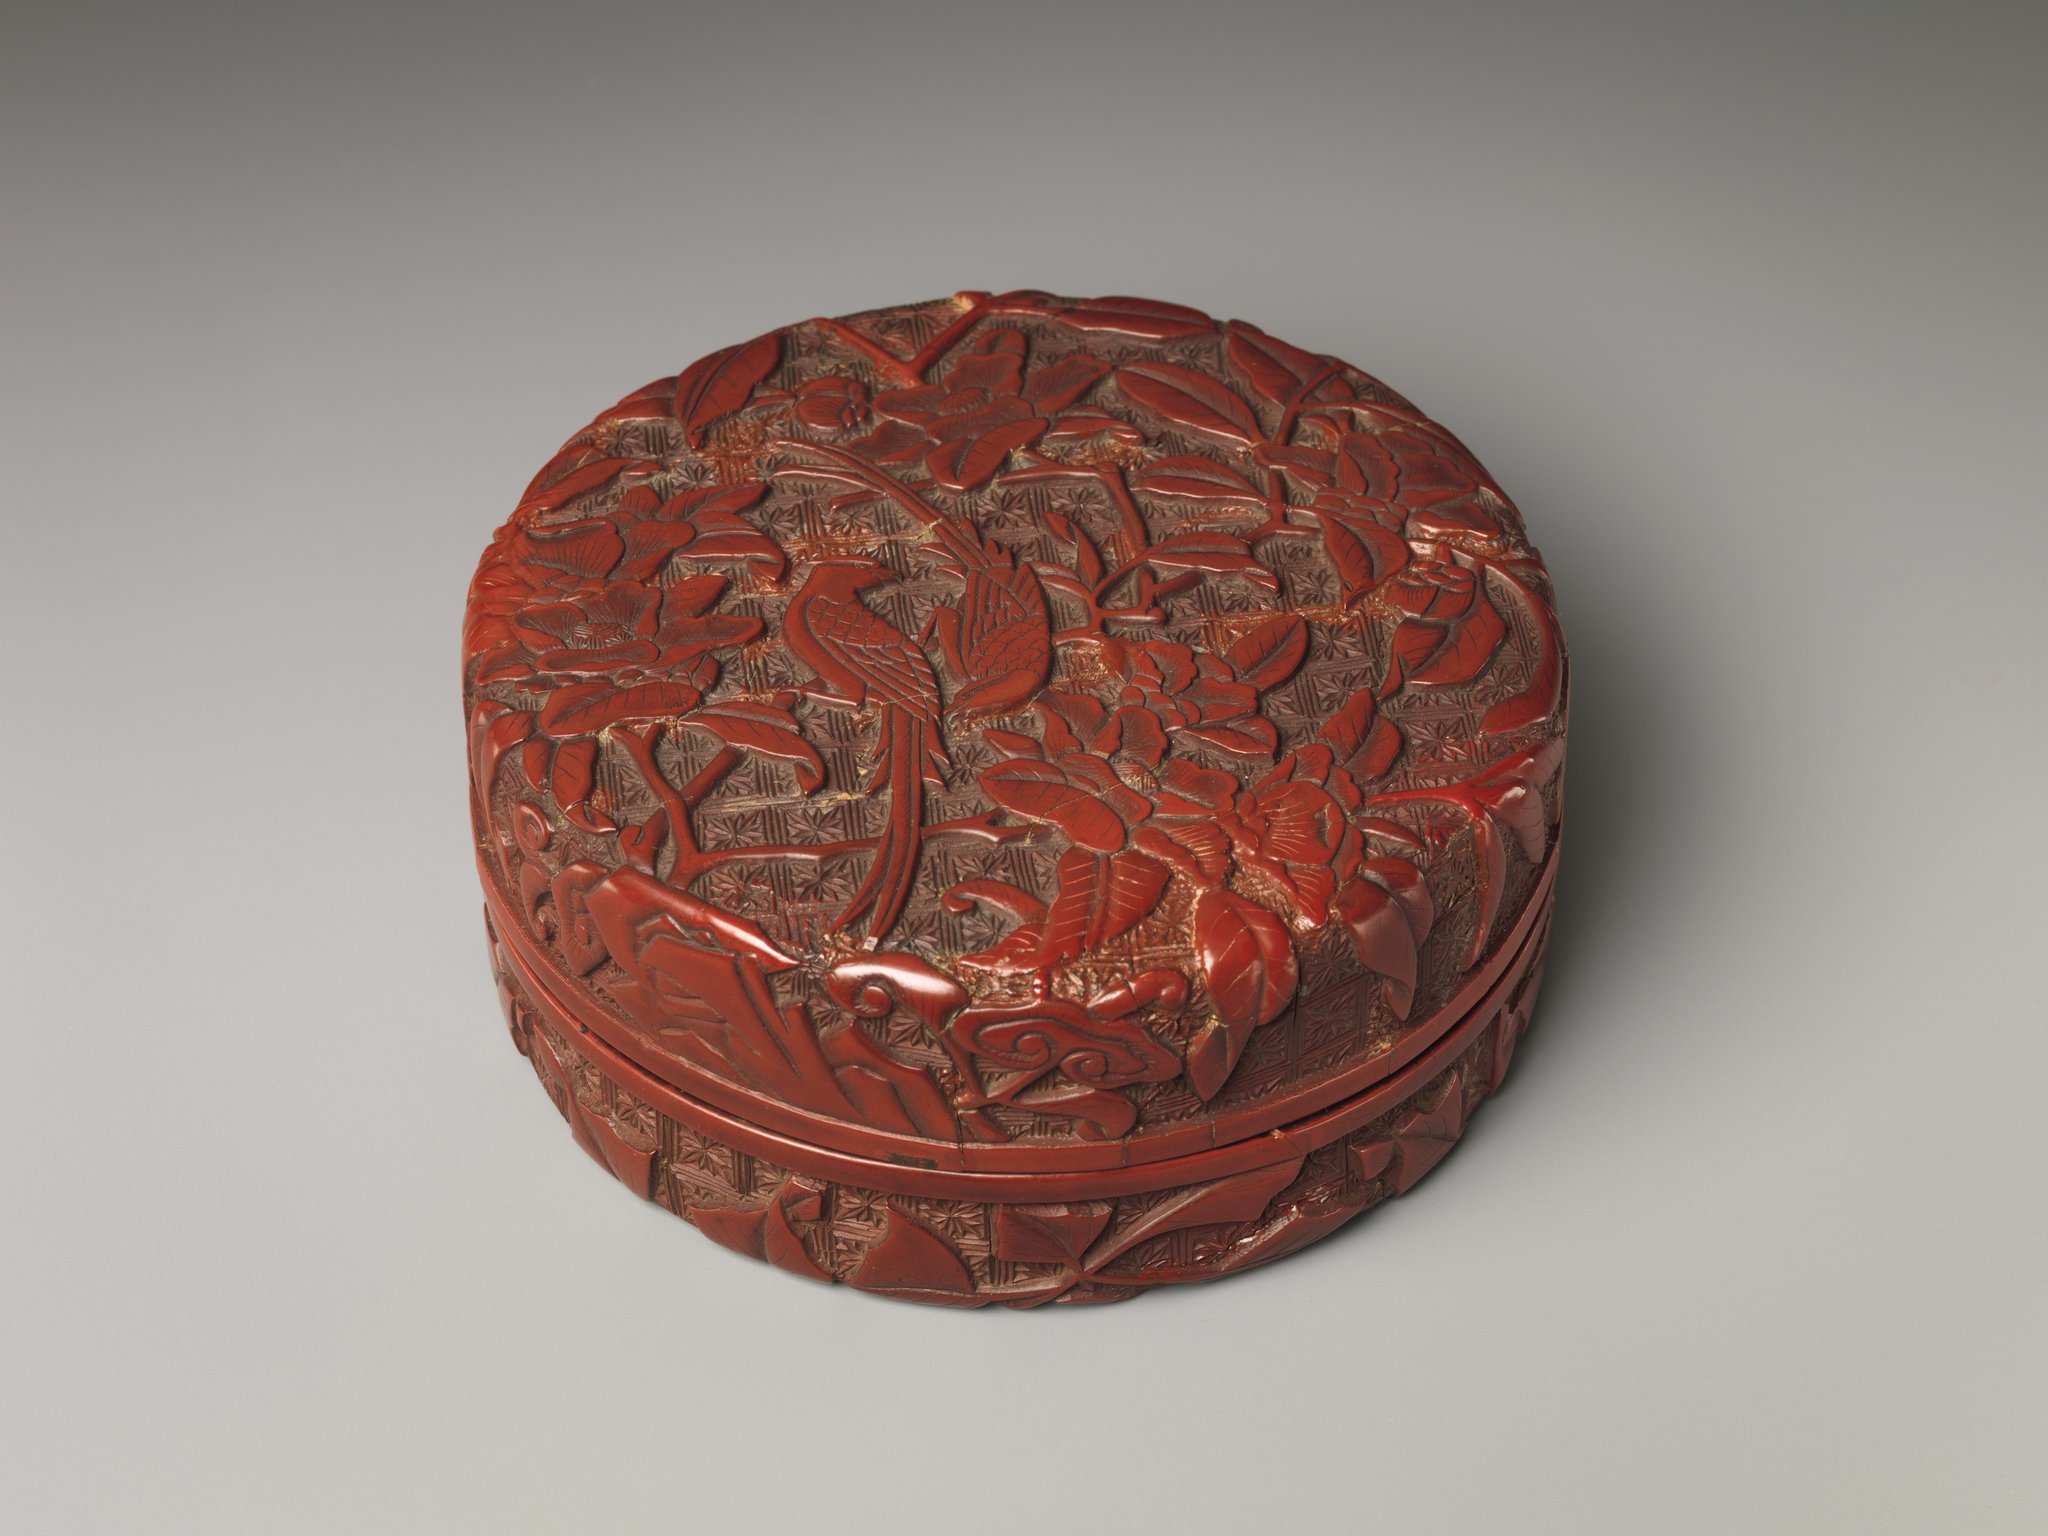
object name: box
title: Box with long-tailed birds and peonies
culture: chinese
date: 1551-1600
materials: lacquer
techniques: carving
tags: peonies,leaves